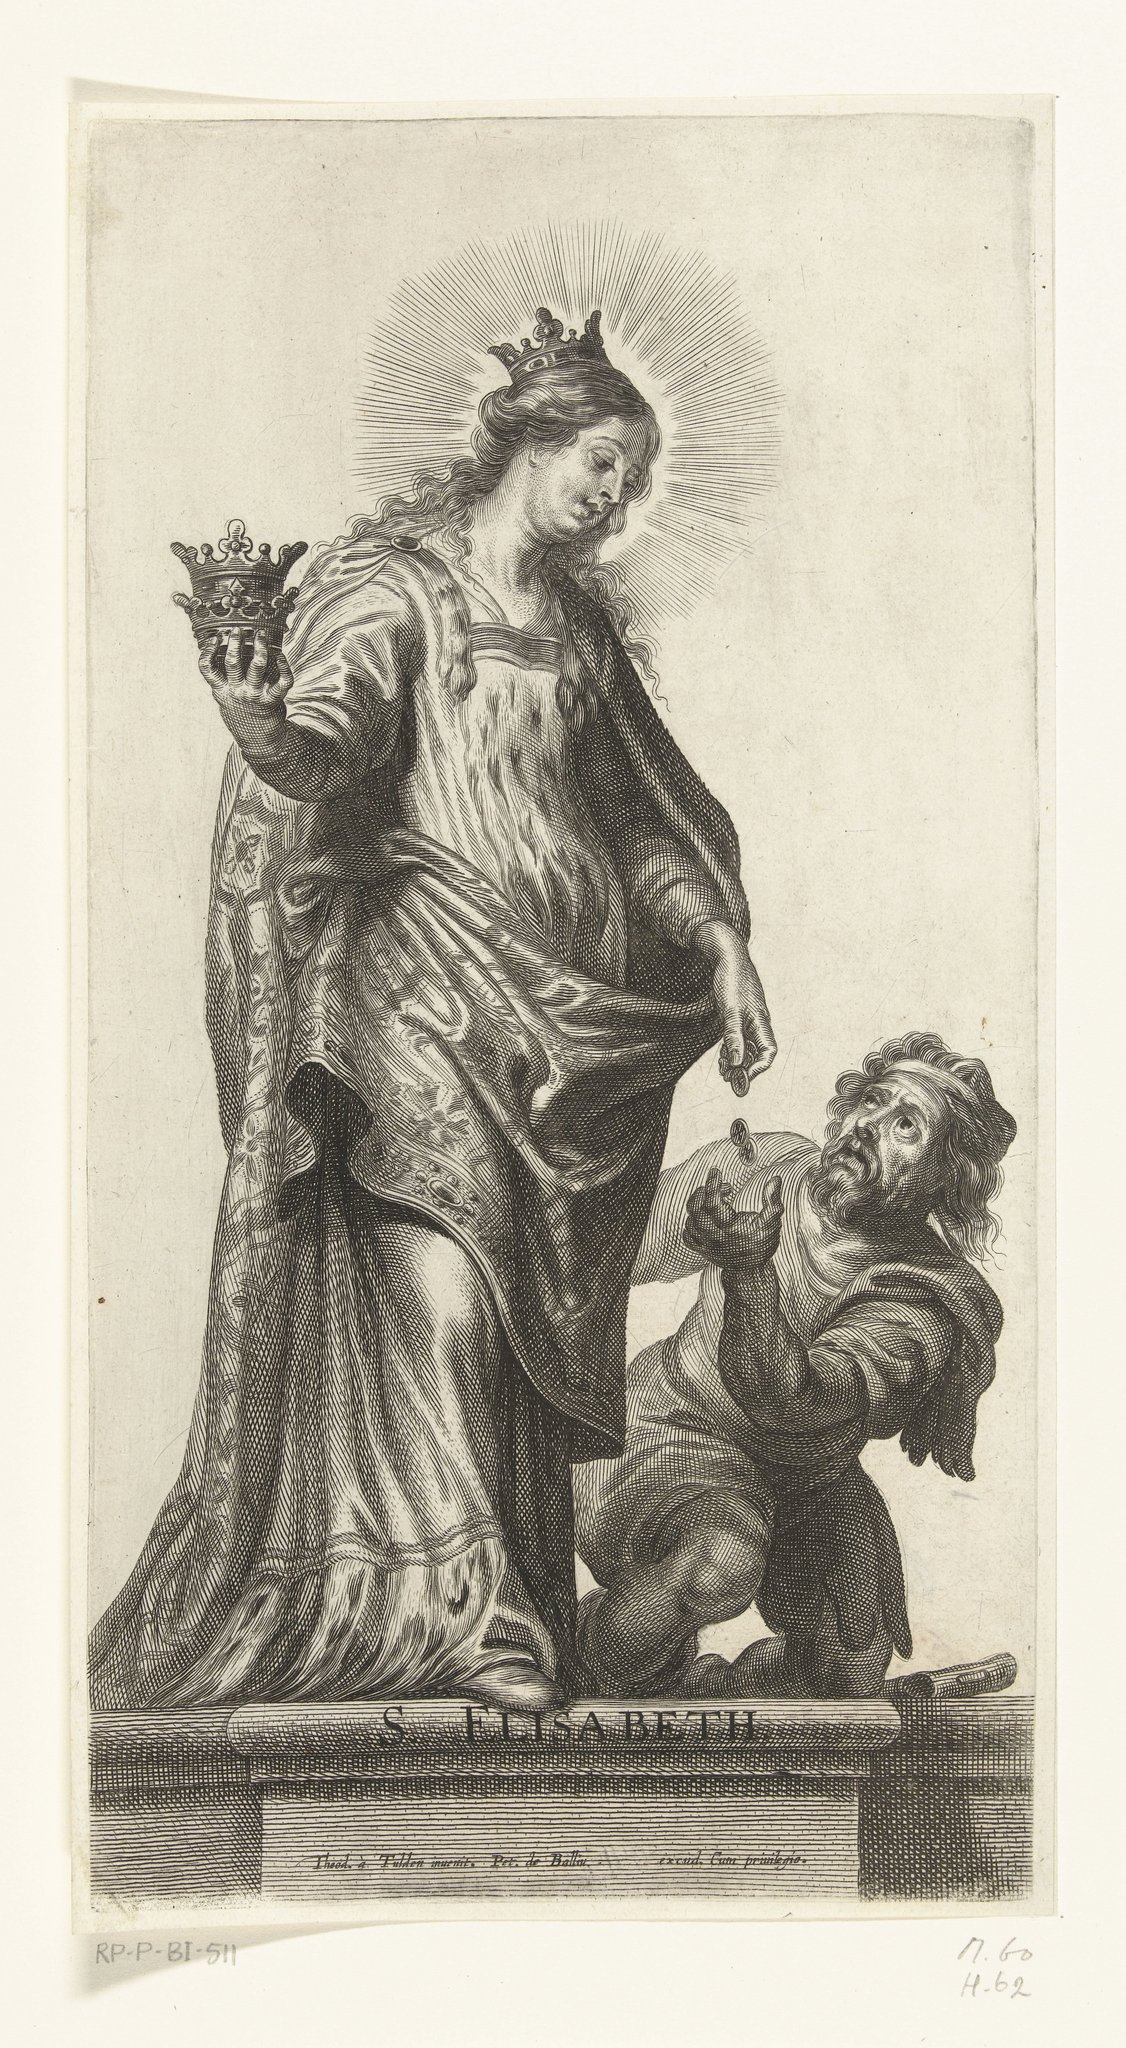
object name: print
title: Heilige Elisabet van Hongarije met kronen geeft bedelaar geld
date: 1623-1660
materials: paper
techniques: engraving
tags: st. elisabeth giving alms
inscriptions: collector's mark: Lugt 240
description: Prent naar ontwerp van Theodoor van Thulden.